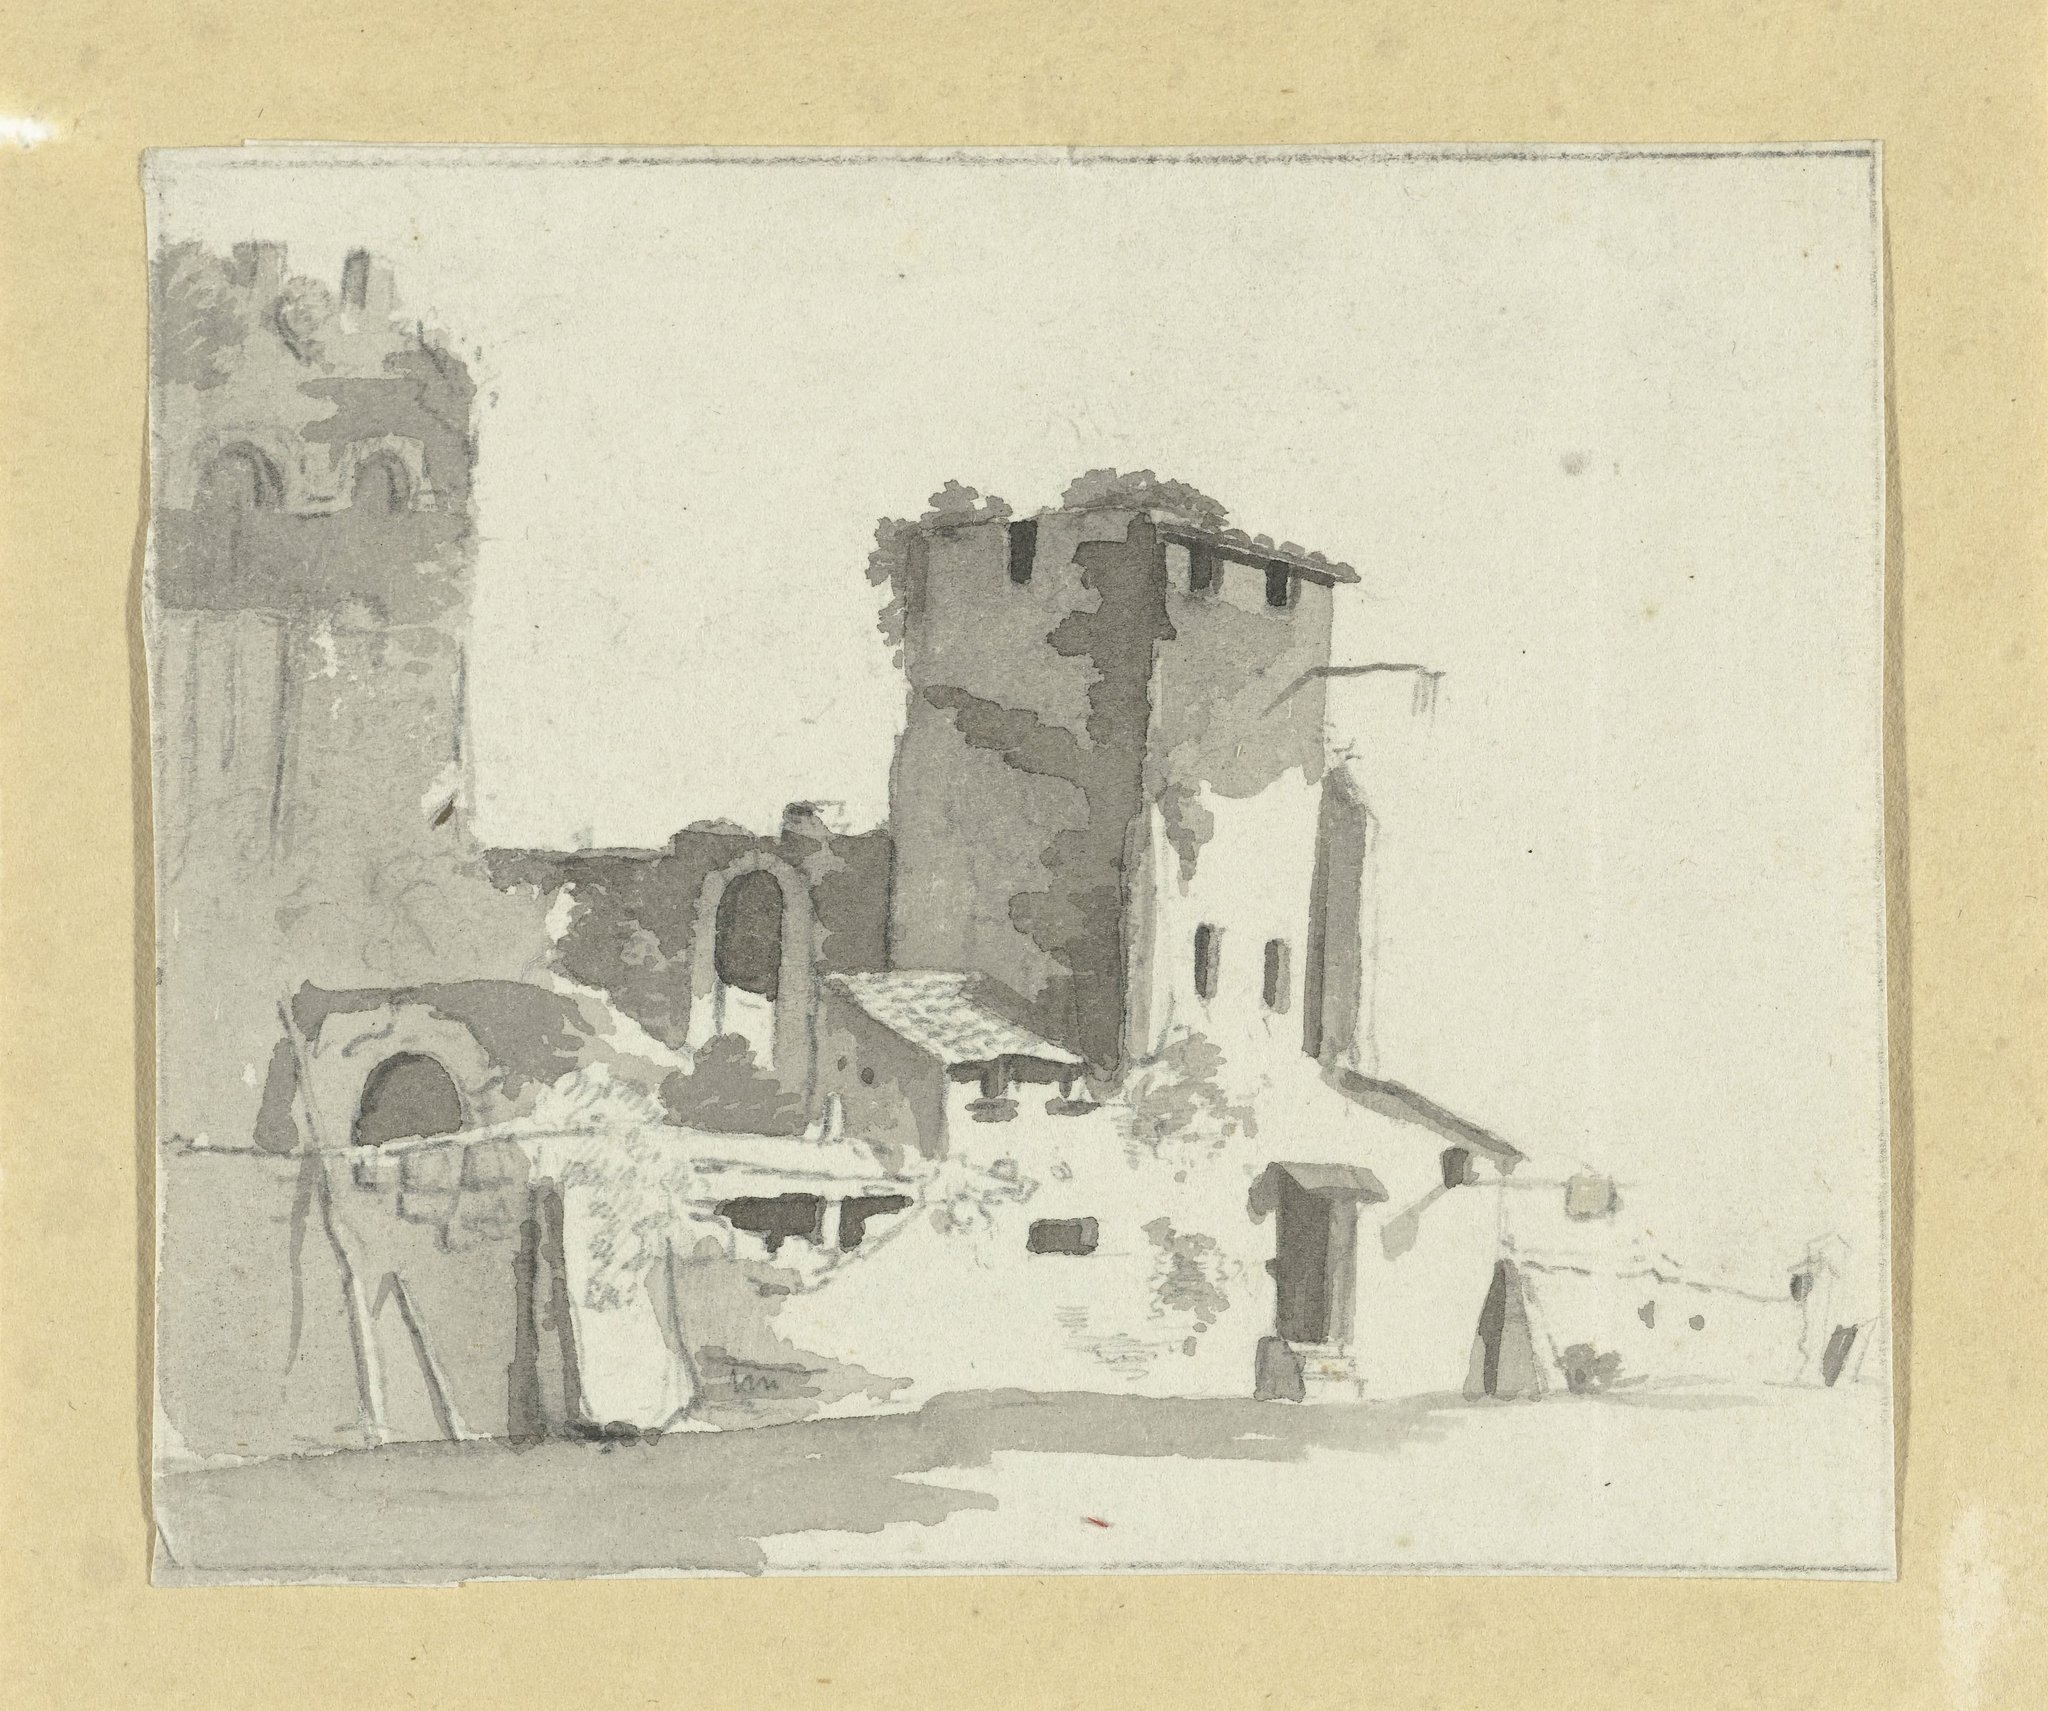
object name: drawing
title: Vervallen gebouwen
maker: pieter gaal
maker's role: draughtsman, print maker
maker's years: 1769-1819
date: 1779-1819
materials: paper, pencil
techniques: brush